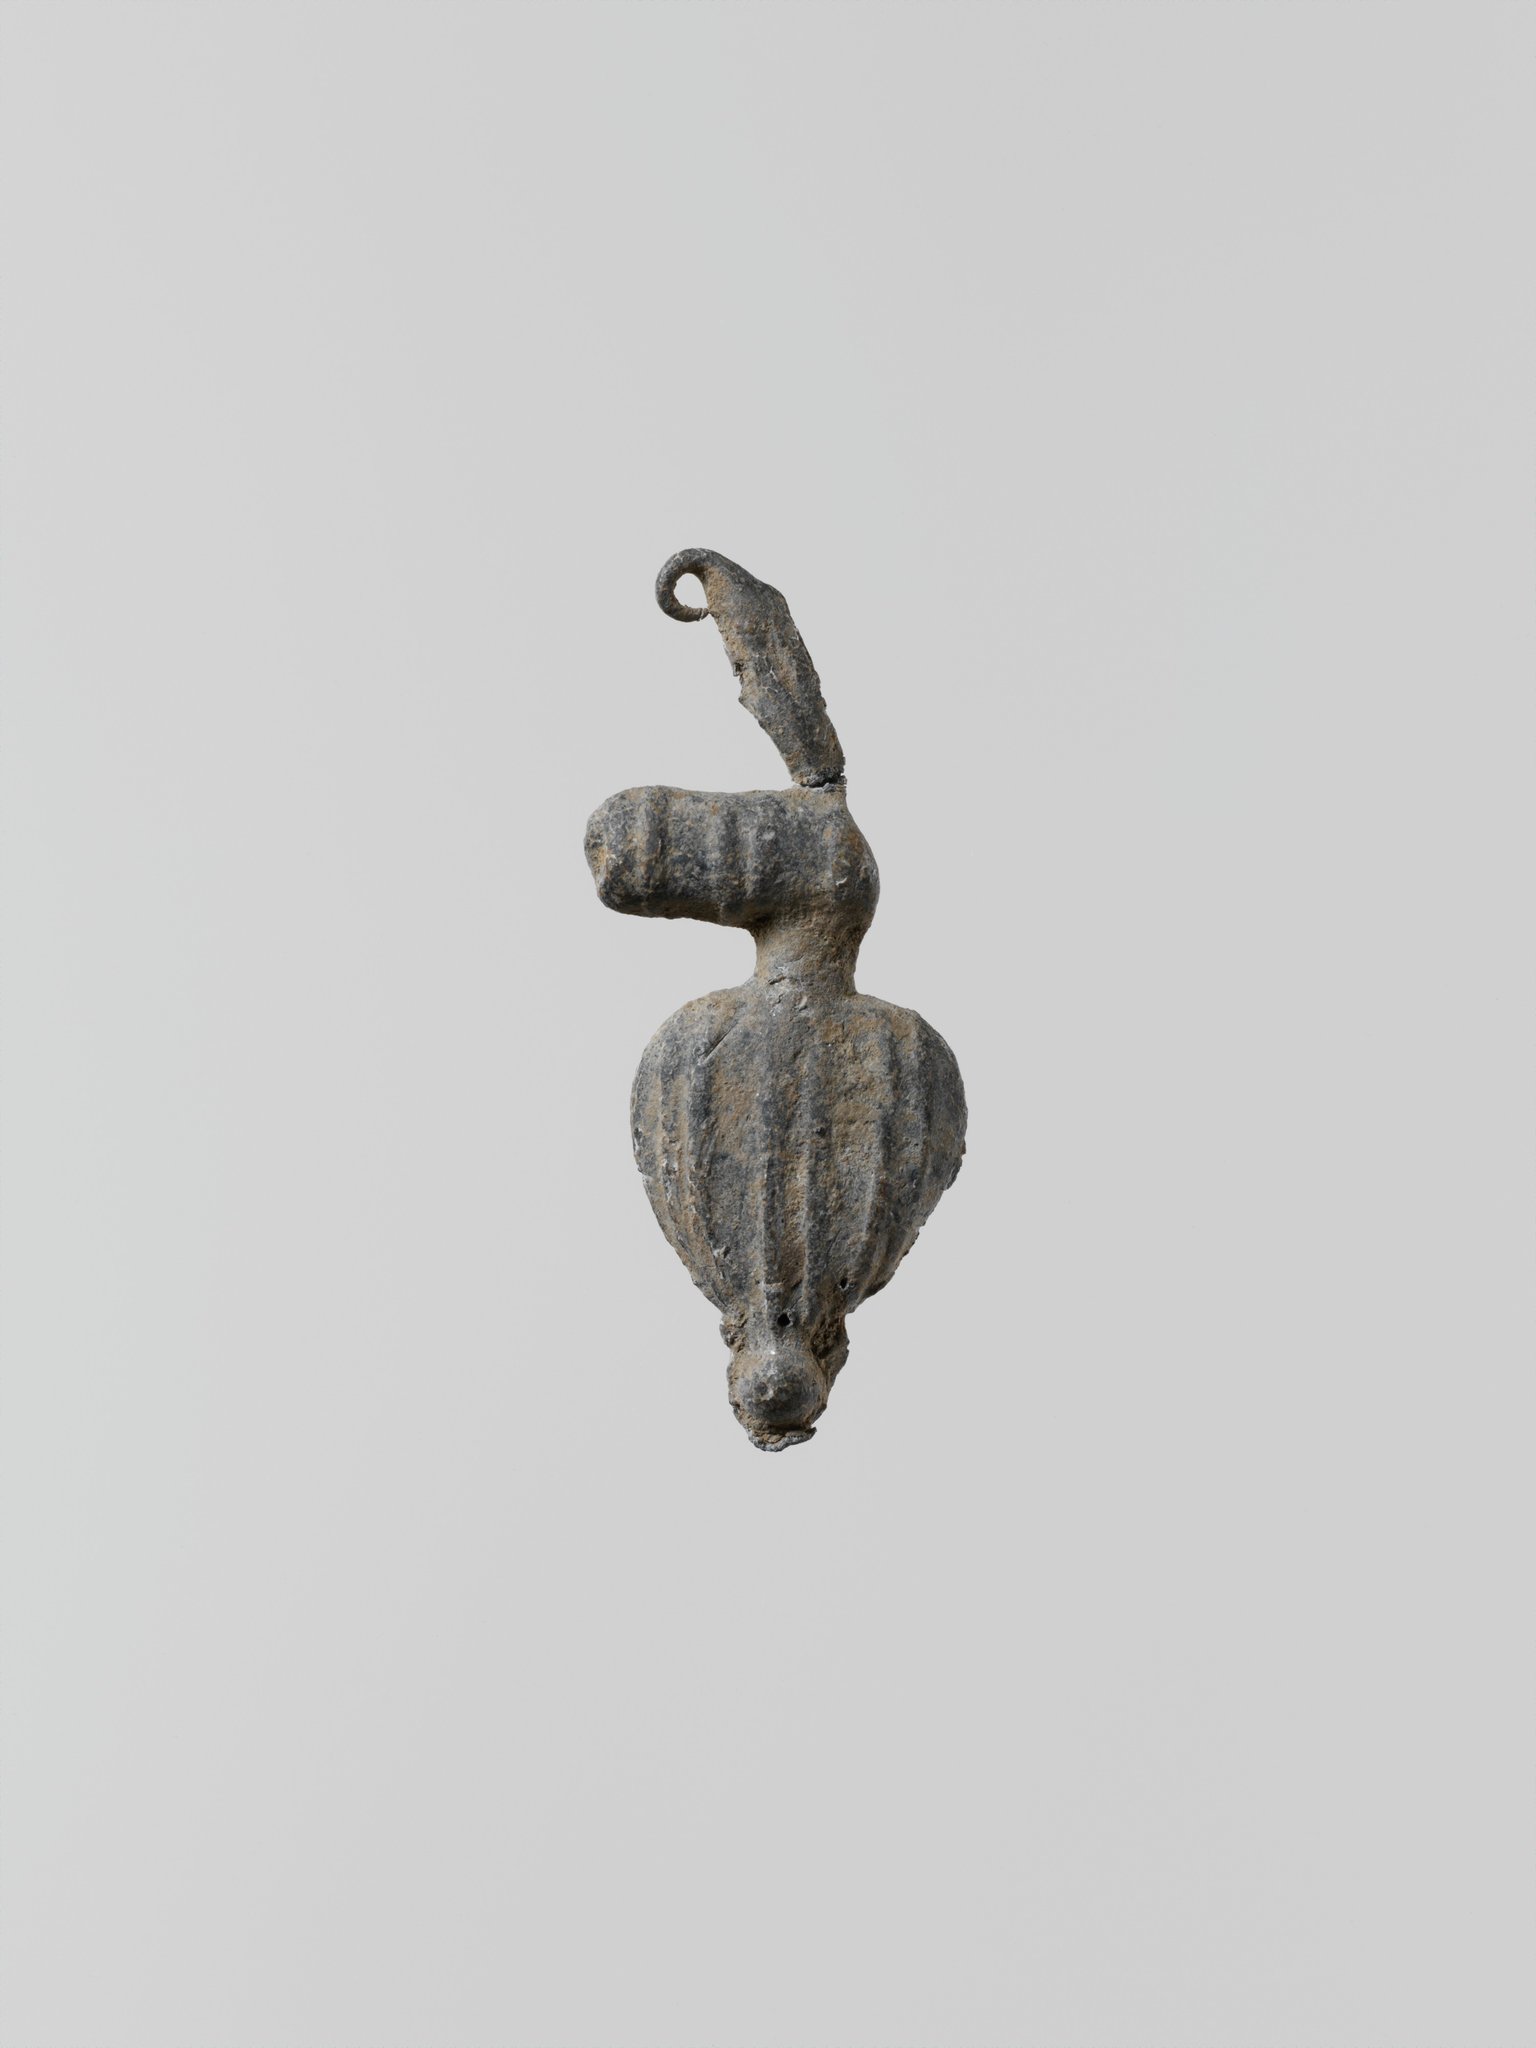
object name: ornament, 4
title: Lead ornament in the form of a bud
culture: greek, laconian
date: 600-401 BCE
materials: lead